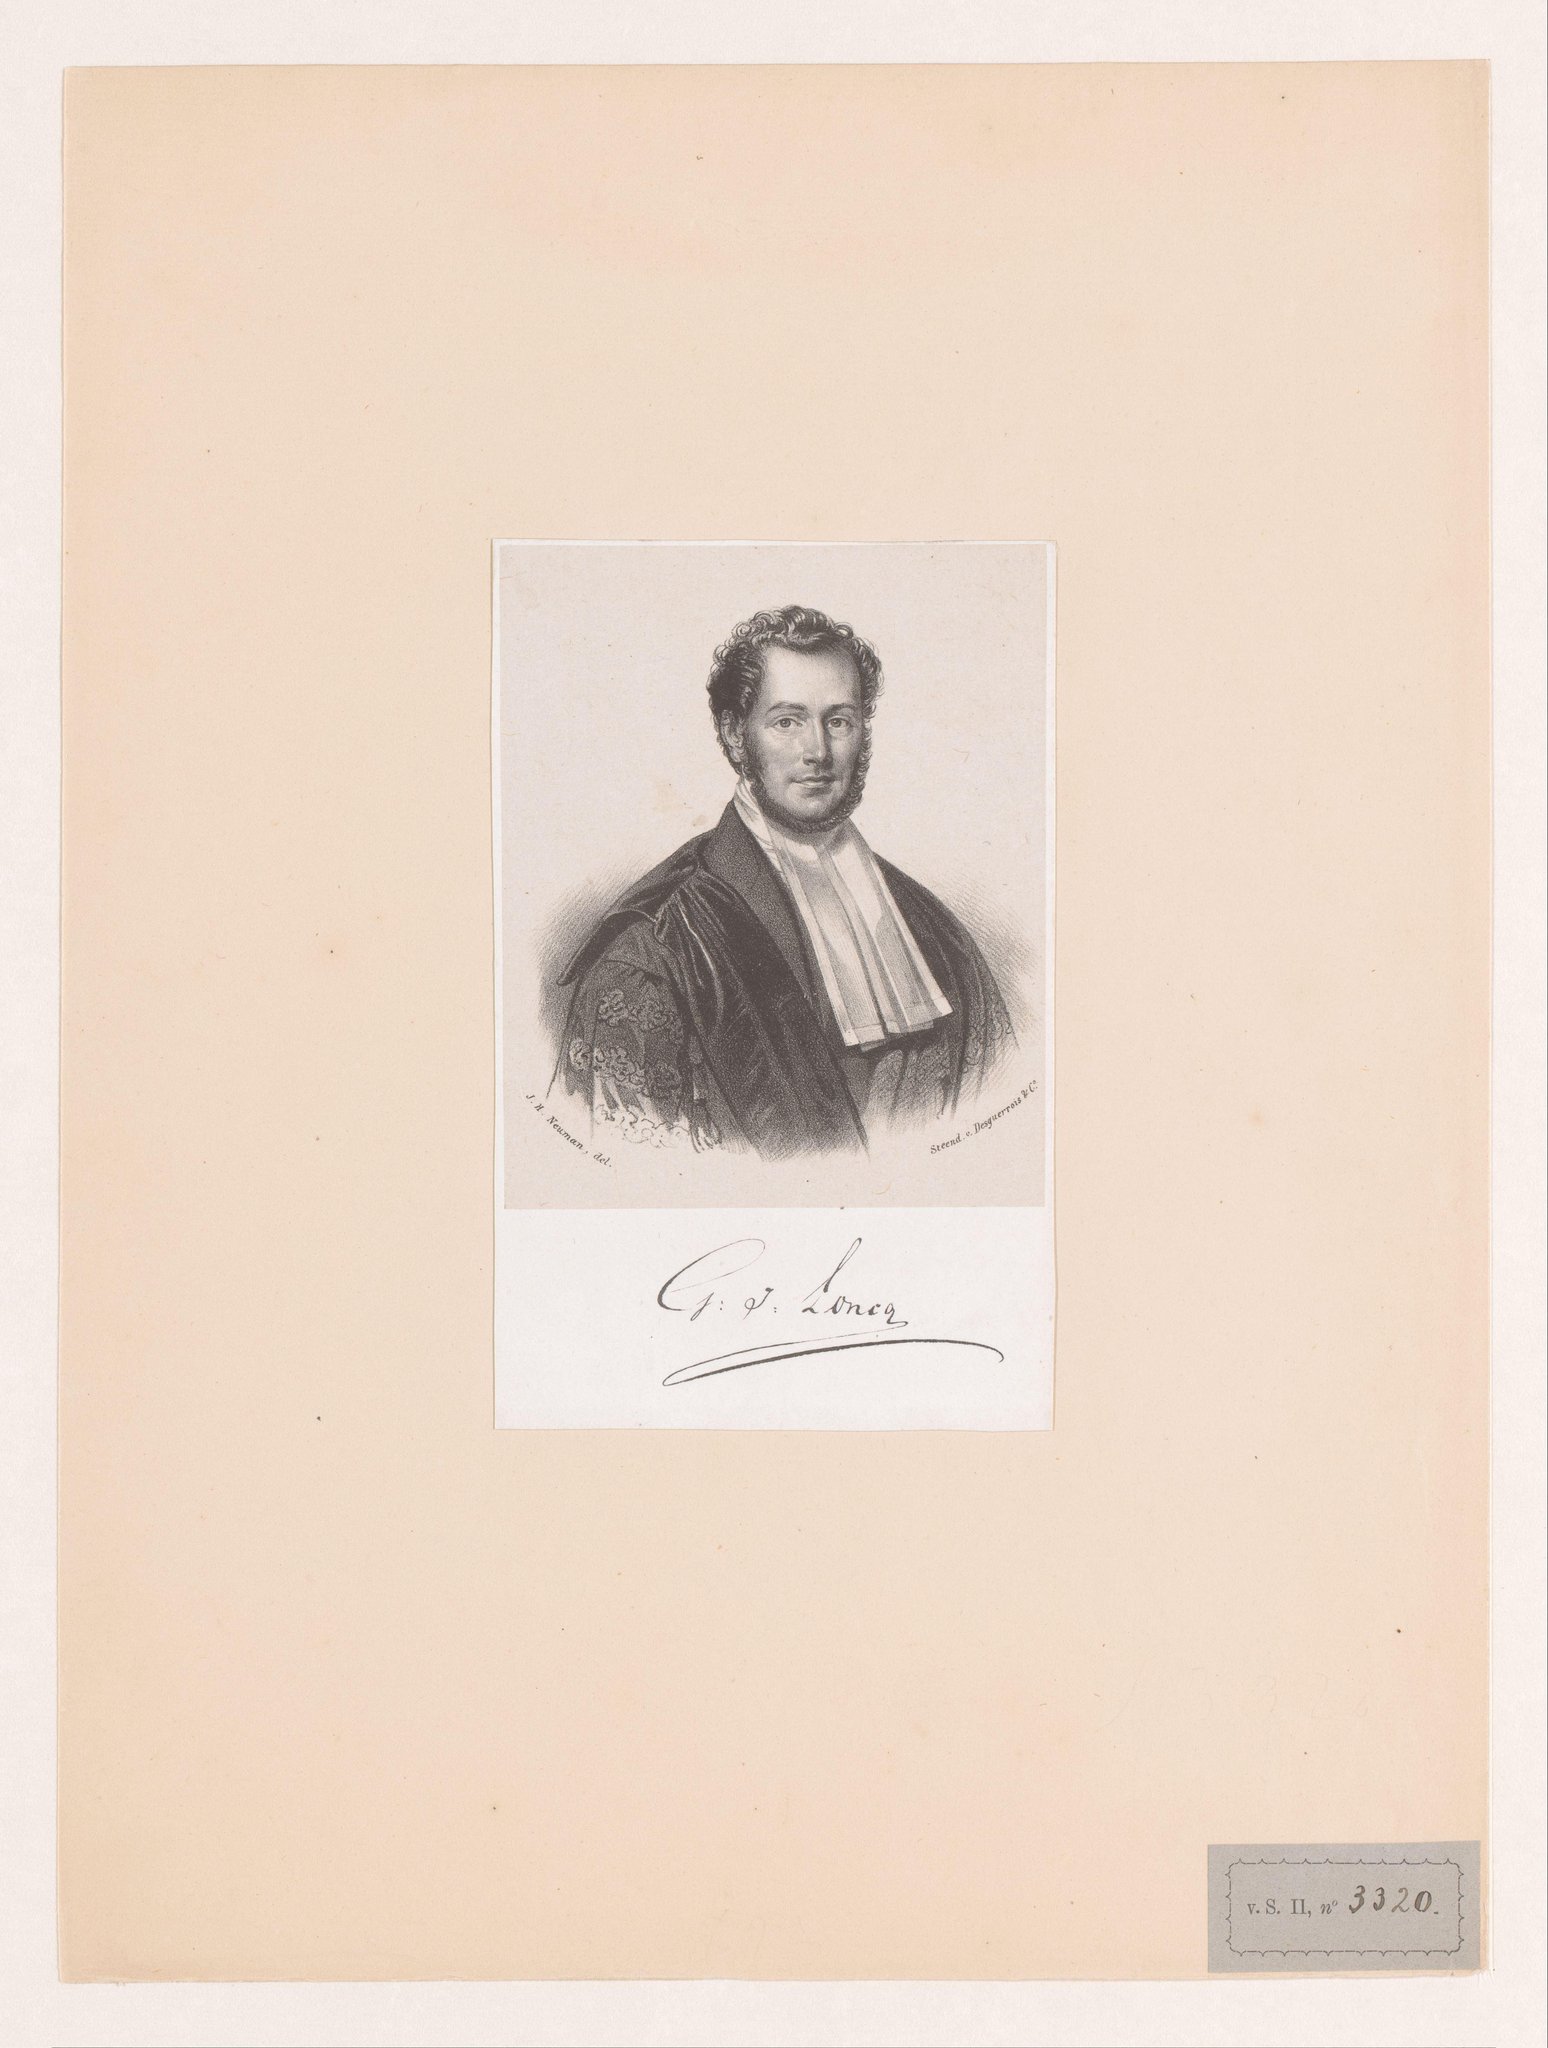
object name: print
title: Portret van Gozewijn Jan Loncq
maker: johan heinrich neuman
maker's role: draughtsman, painter, print maker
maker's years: 1819-1898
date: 1829-1898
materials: paper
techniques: lithograph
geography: netherlands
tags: utrecht, historical persons (+ (full) bust portrait)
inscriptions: collector's mark: Lugt 2228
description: De geportretteerde draagt een ringbaard, een toga en een bef. Onder het portret zijn signatuur.